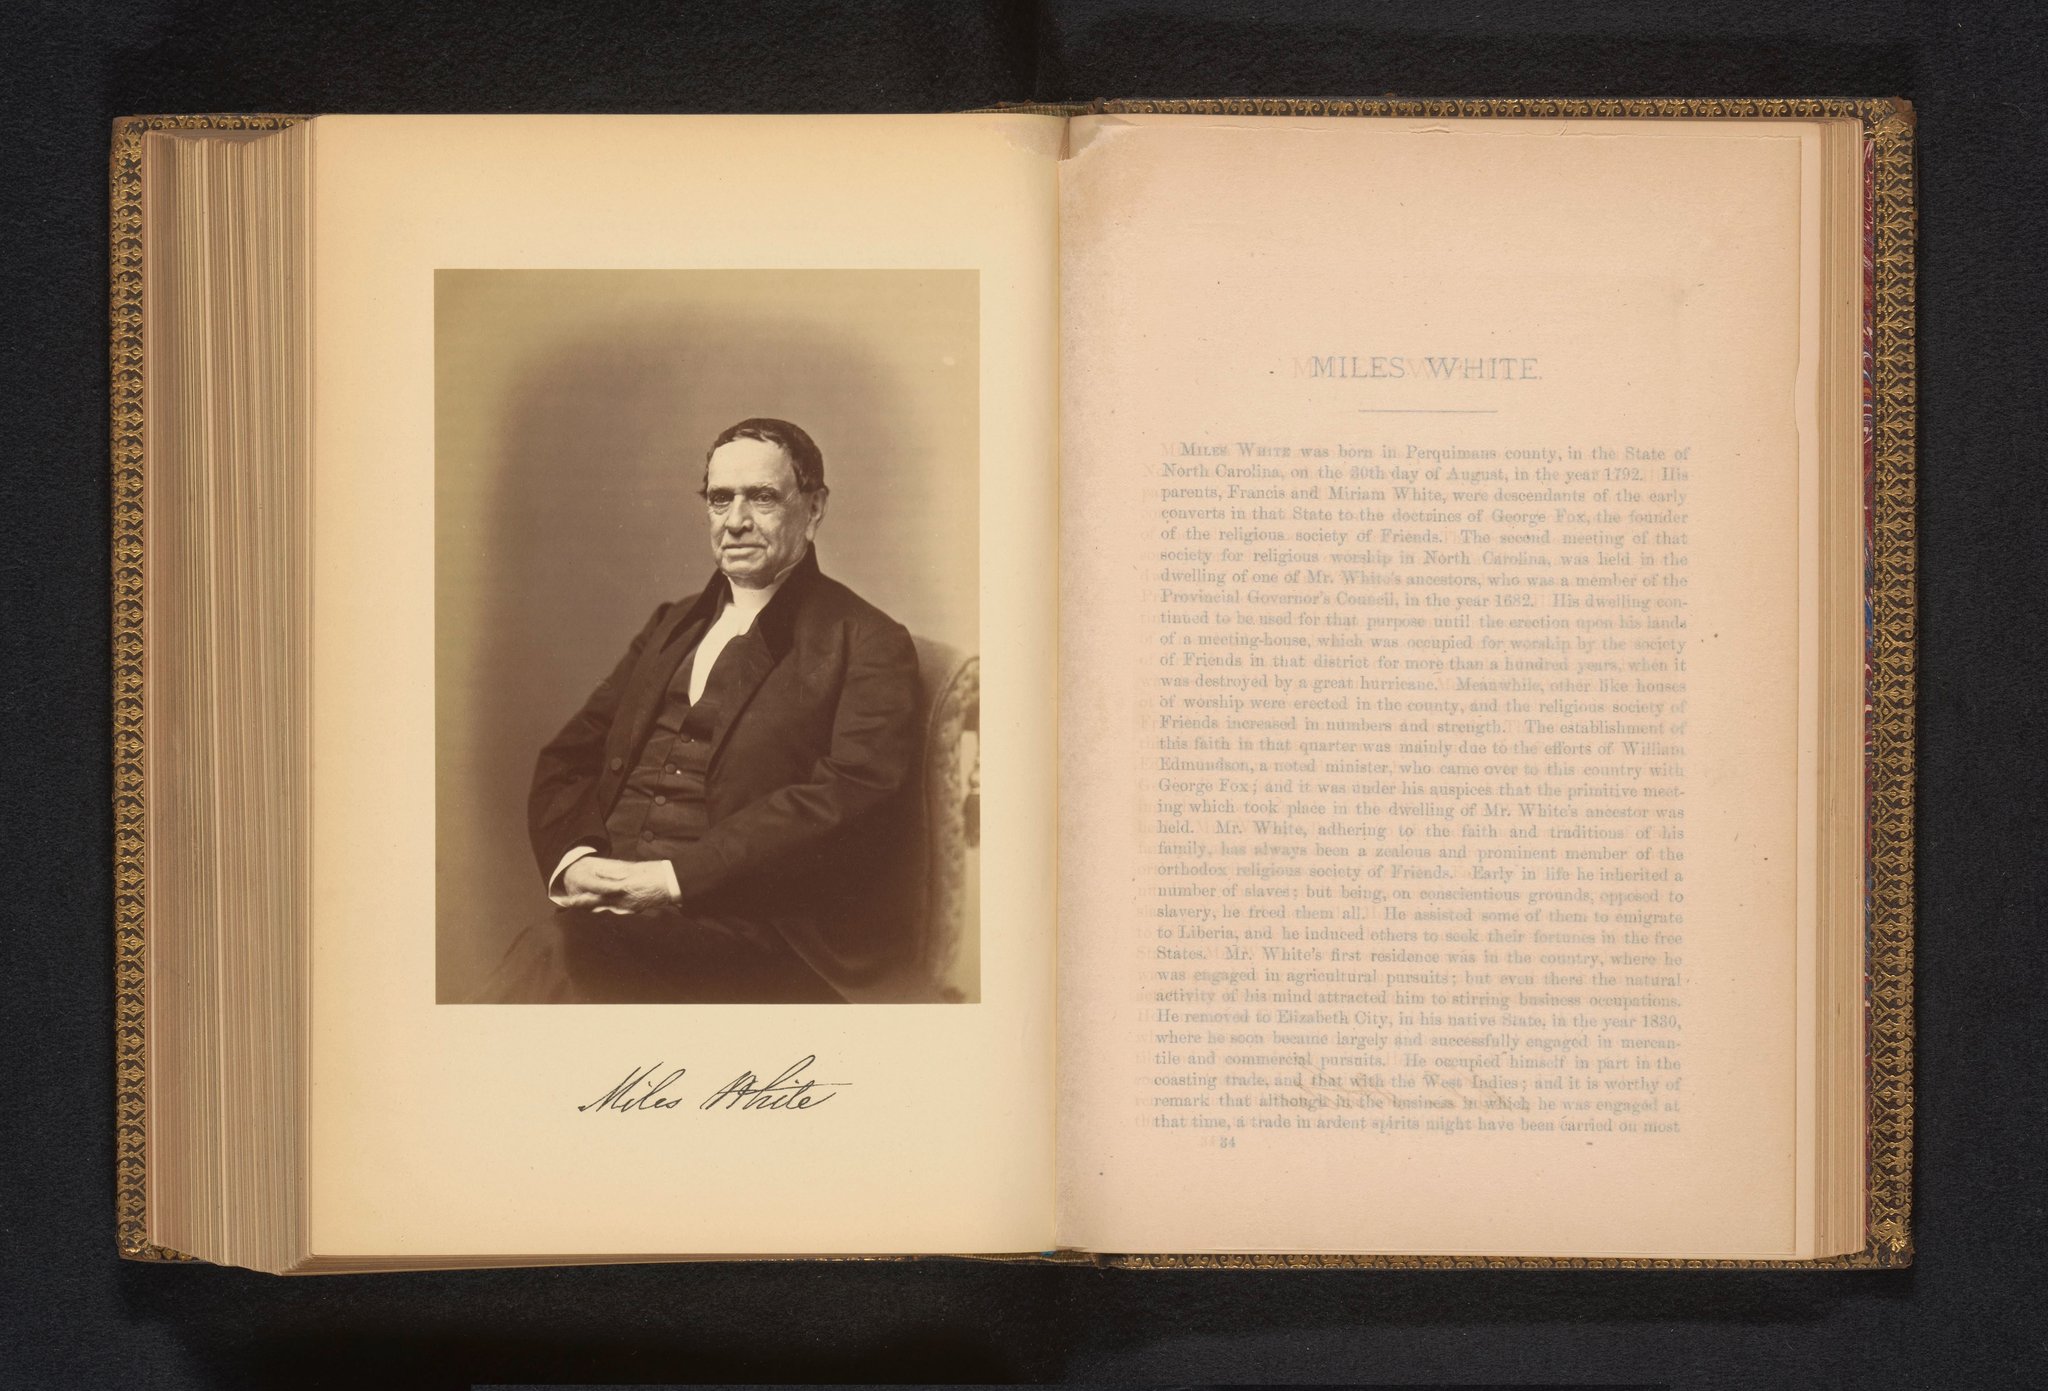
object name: photograph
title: Miles White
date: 1866-1871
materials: photographic support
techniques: albumen print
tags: historical persons